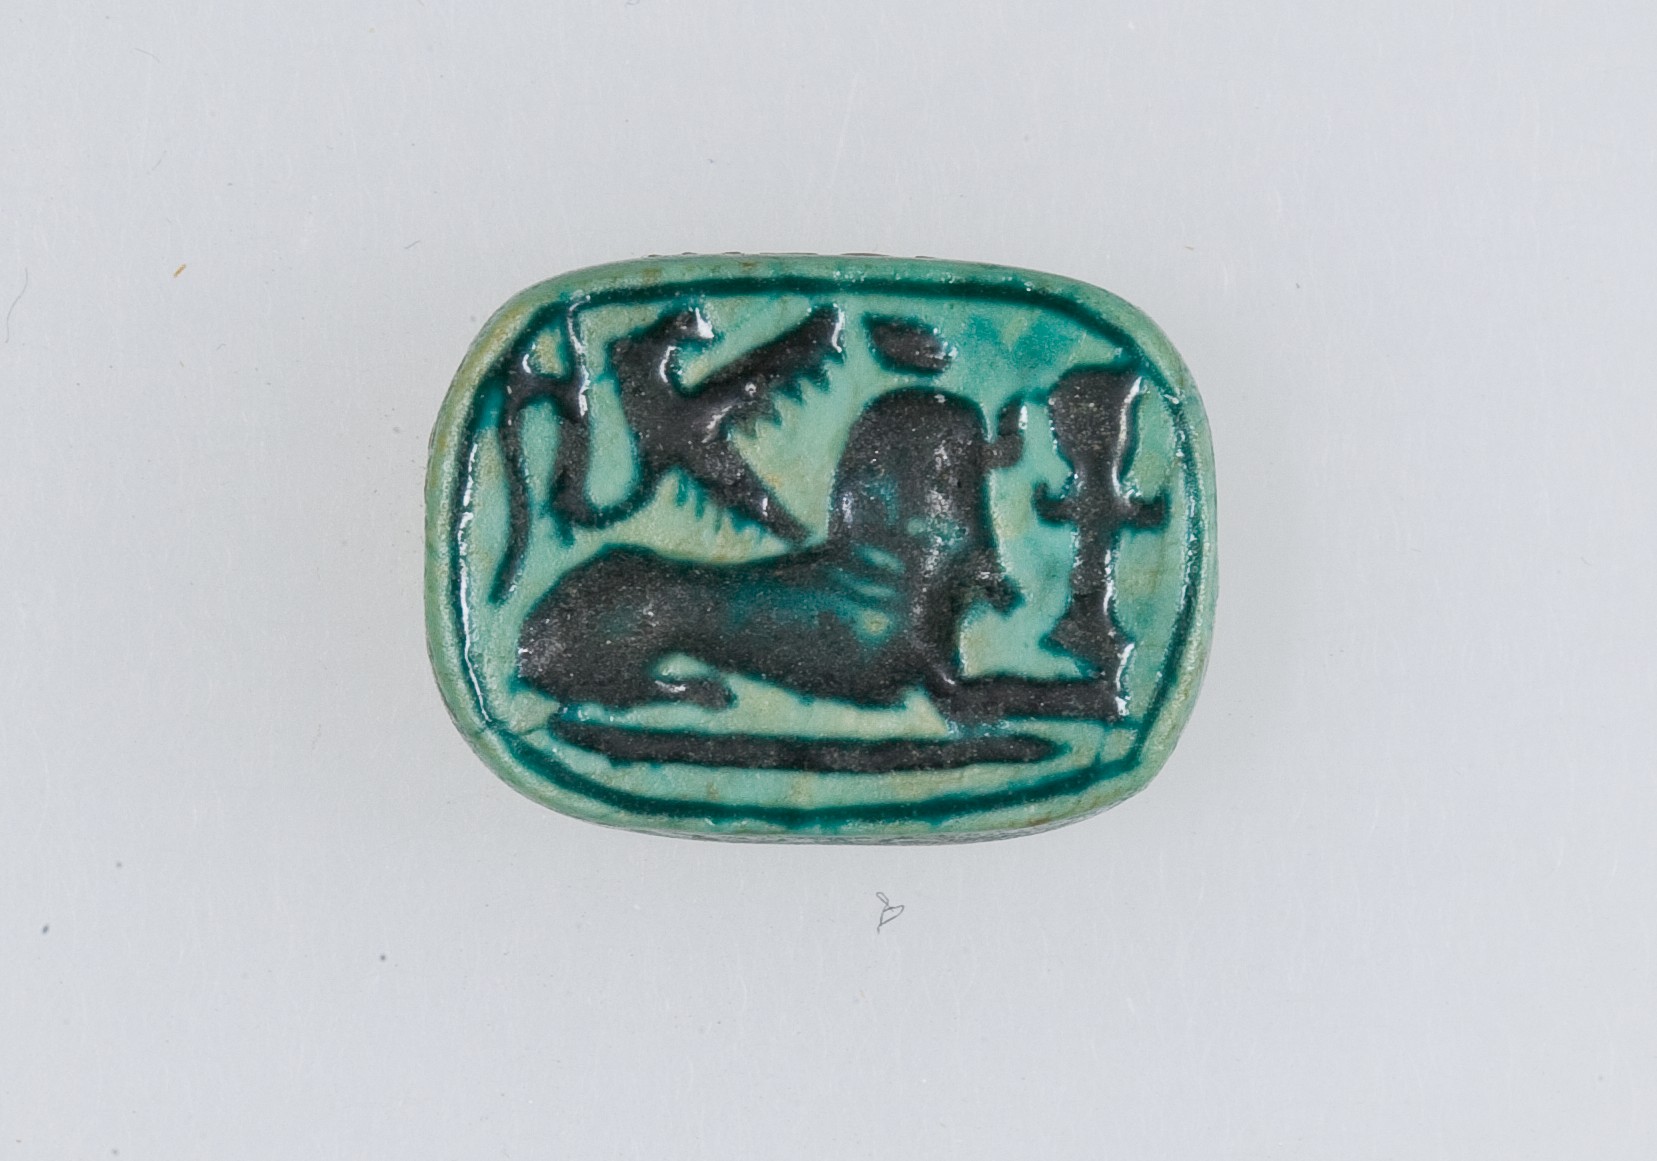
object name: bead plaque, thutmose iv, sphinx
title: Plaque Bead with Name of Thutmose IV and a Sphinx on the Reverse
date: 1400-1390 BCE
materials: stone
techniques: glazing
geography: egypt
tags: sphinx